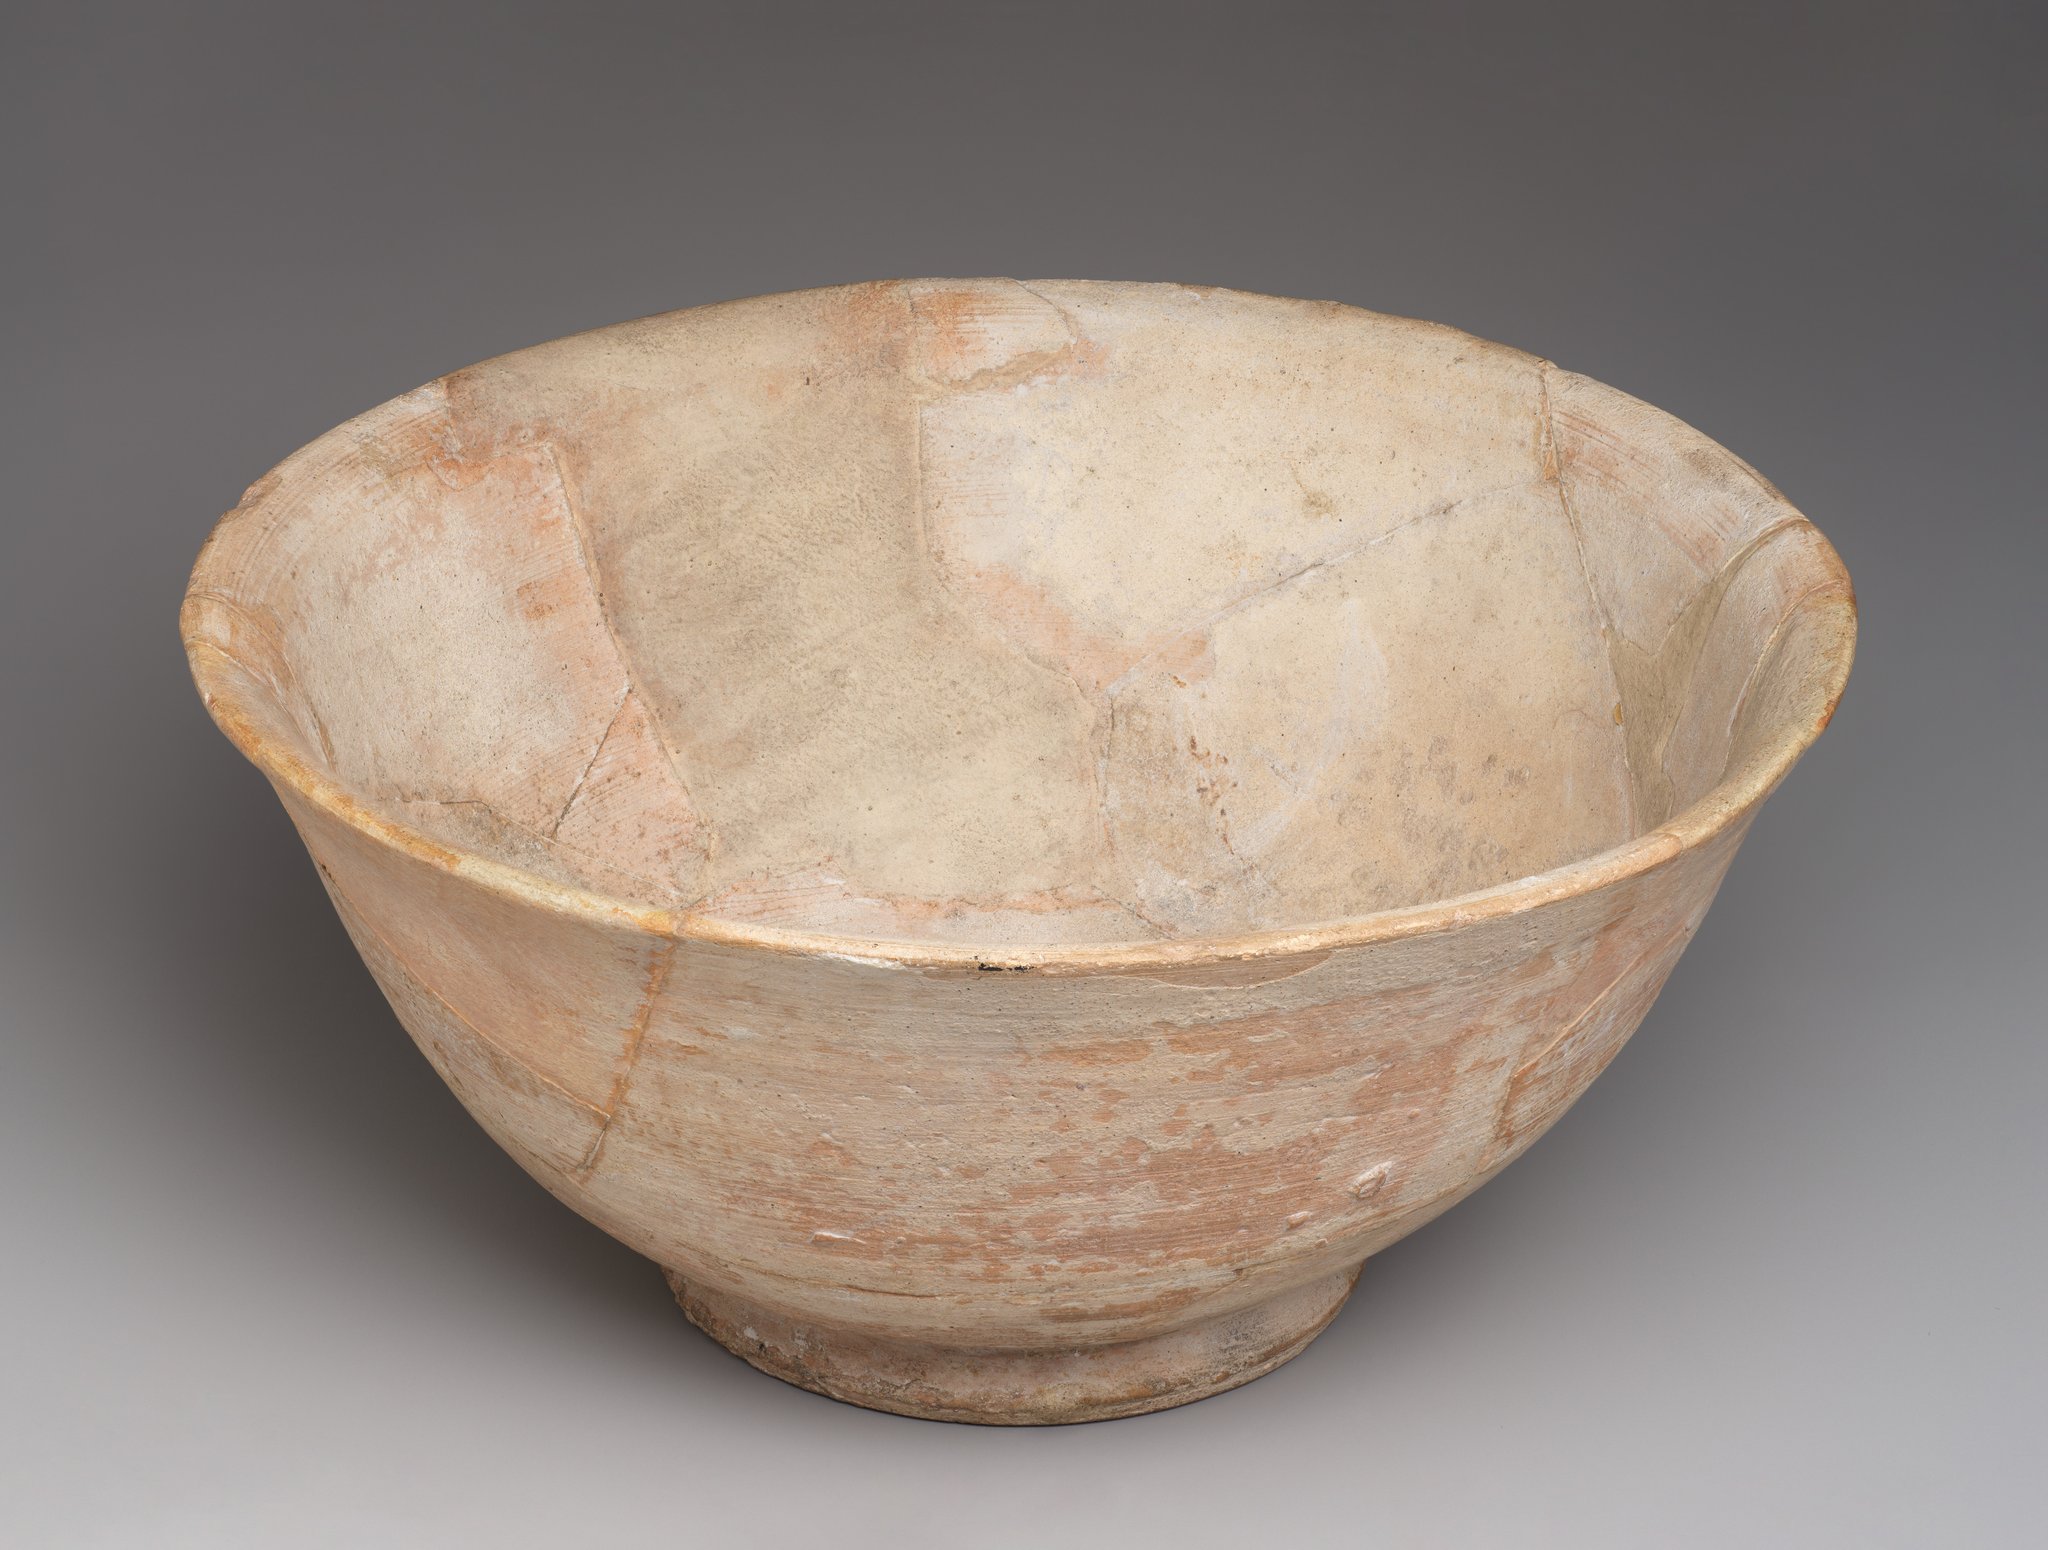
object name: bowl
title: Glazed bowl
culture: sasanian or islamic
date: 501-800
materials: ceramic, glaze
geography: iran